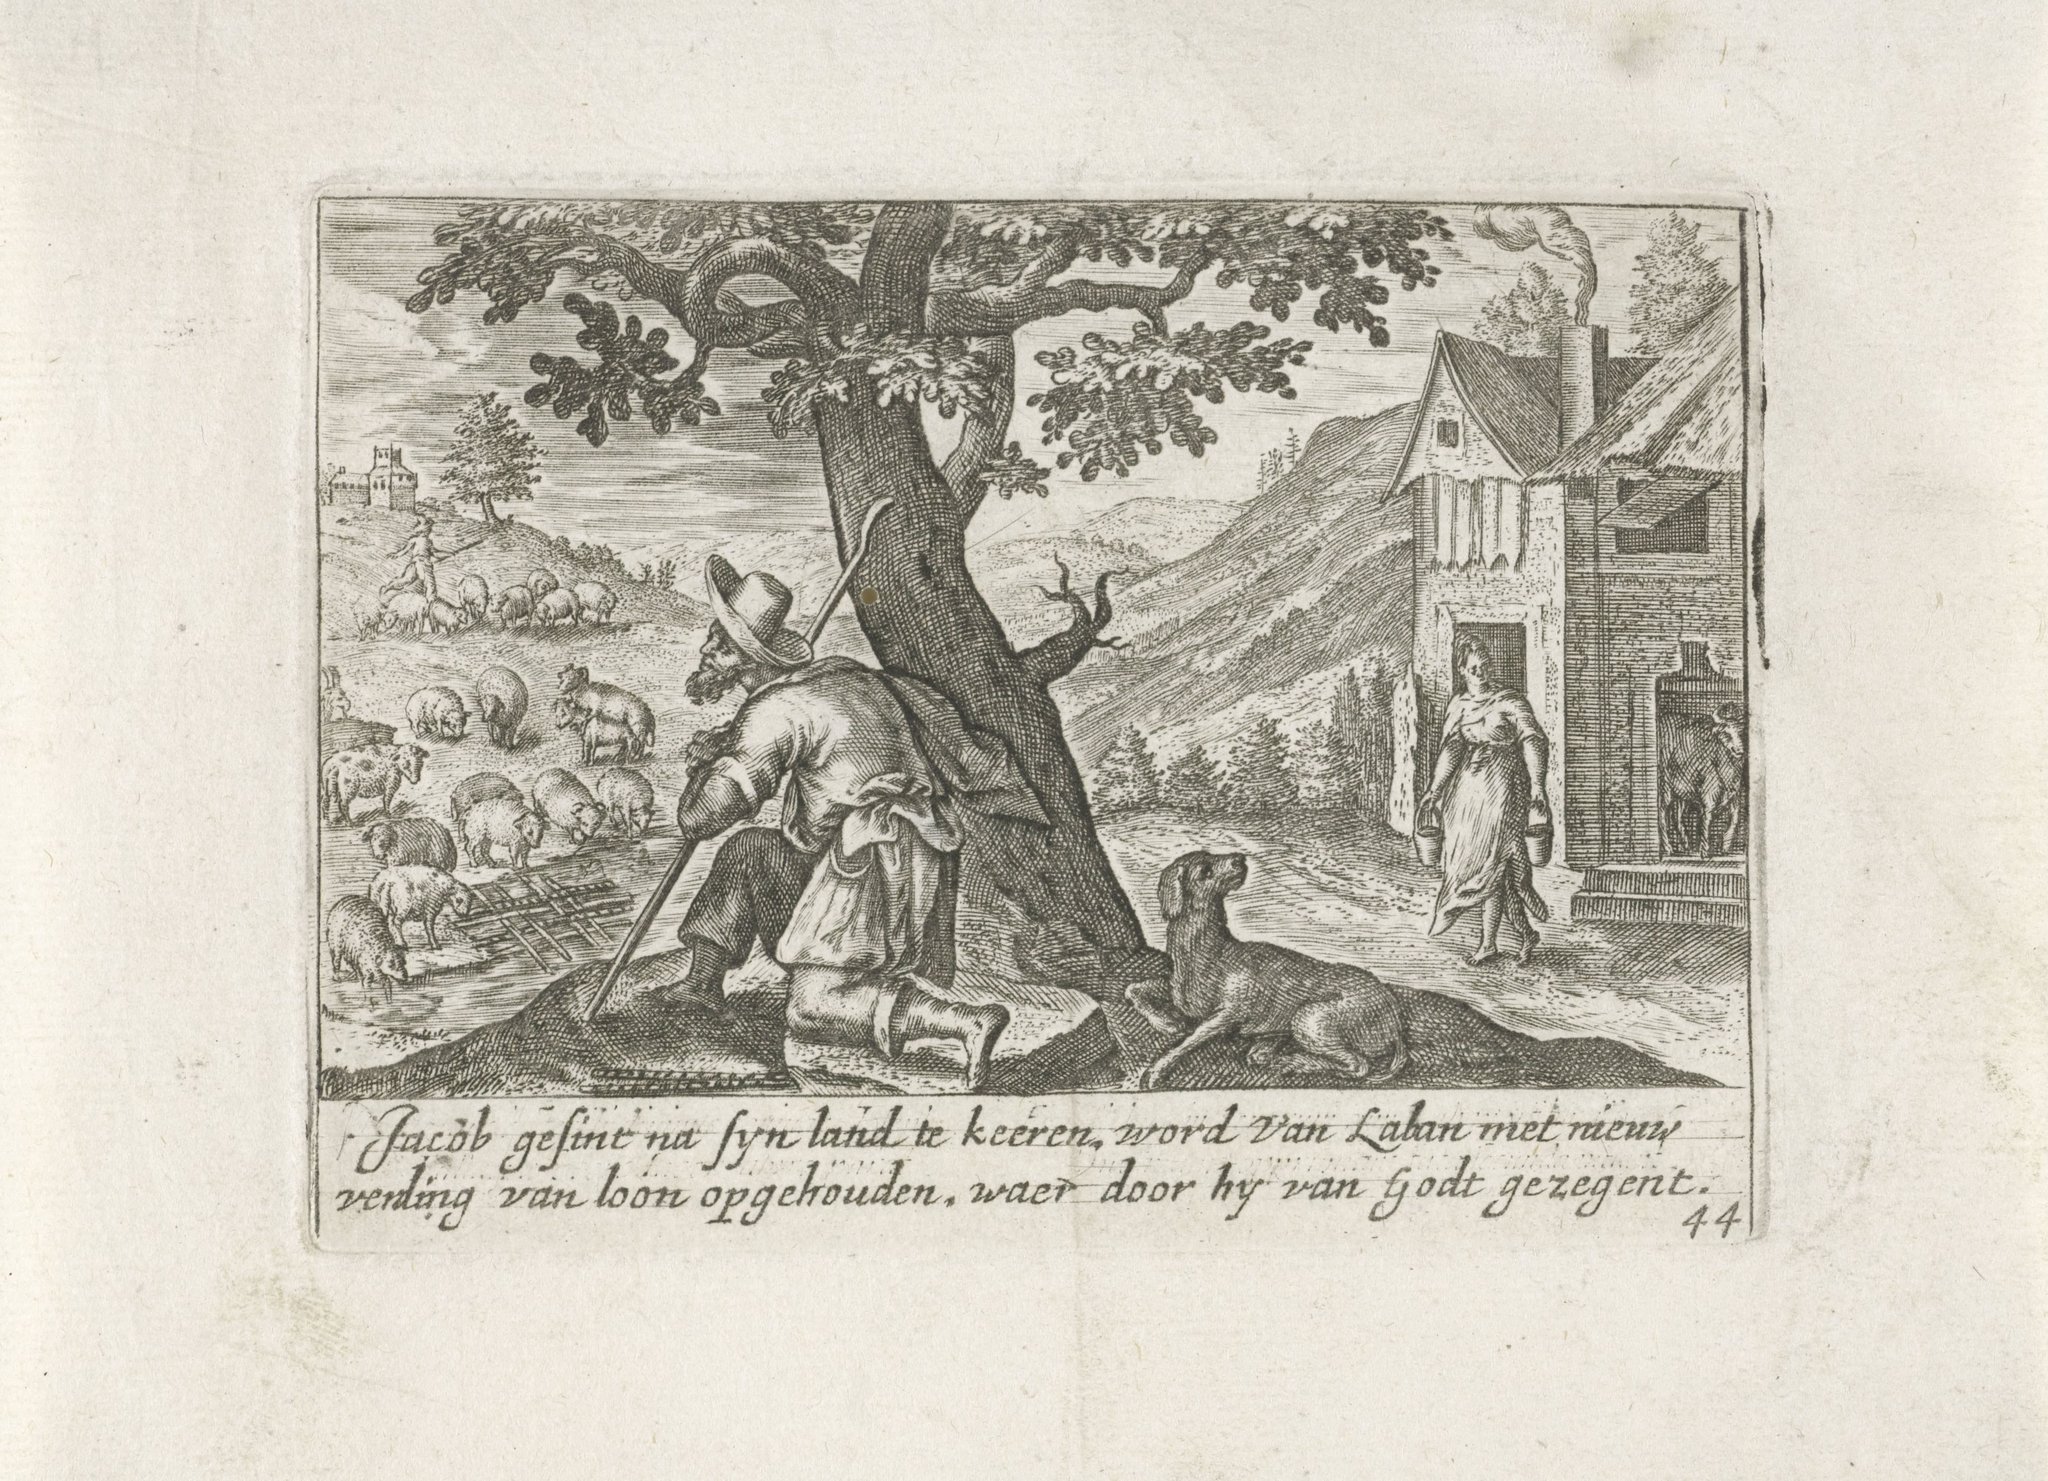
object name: print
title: Jakob verrijkt zich met schapen uit de kudde van Laban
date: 1700-1750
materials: paper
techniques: engraving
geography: amsterdam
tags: jacob becomes very rich, jacob puts peeled rods in the animals' drinking troughs to make the beasts bear spotted young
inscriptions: collector's mark: Lugt 2233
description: Jakob heeft afgeschilde takken in de drinkbakken van de schapen gelegd om ervoor te zorgen dat de witte schapen bont gevlekte jongen werpen. Daarmee misleidt hij Laban die met hem heeft afgesproken dat hij alle bonte dieren als loon zal ontvangen (Gen. 30:37). Hij kijkt toe hoe de schapen de takken eten. In de marge een tweeregelig onderschrift in het Nederlands.